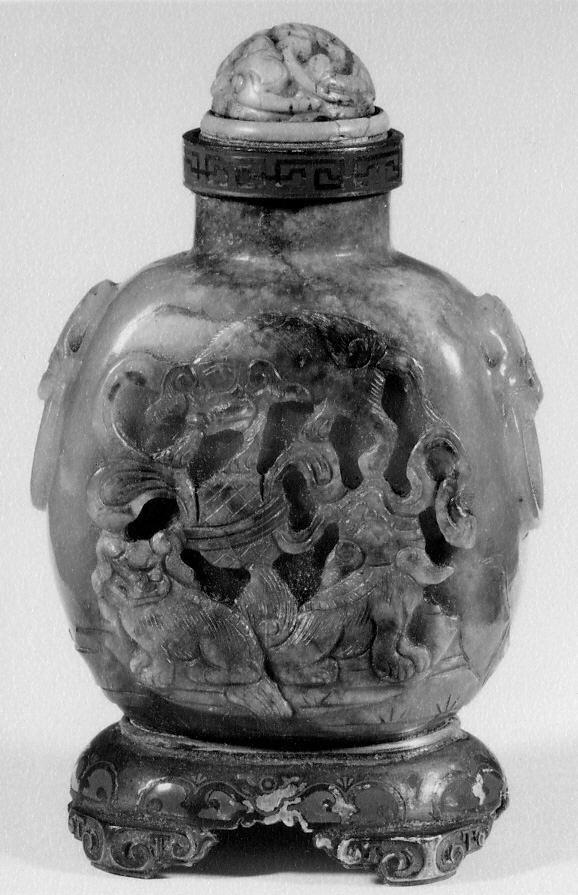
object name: snuff bottle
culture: chinese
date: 1801-1900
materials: coral, enamel, jade, silver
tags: animals